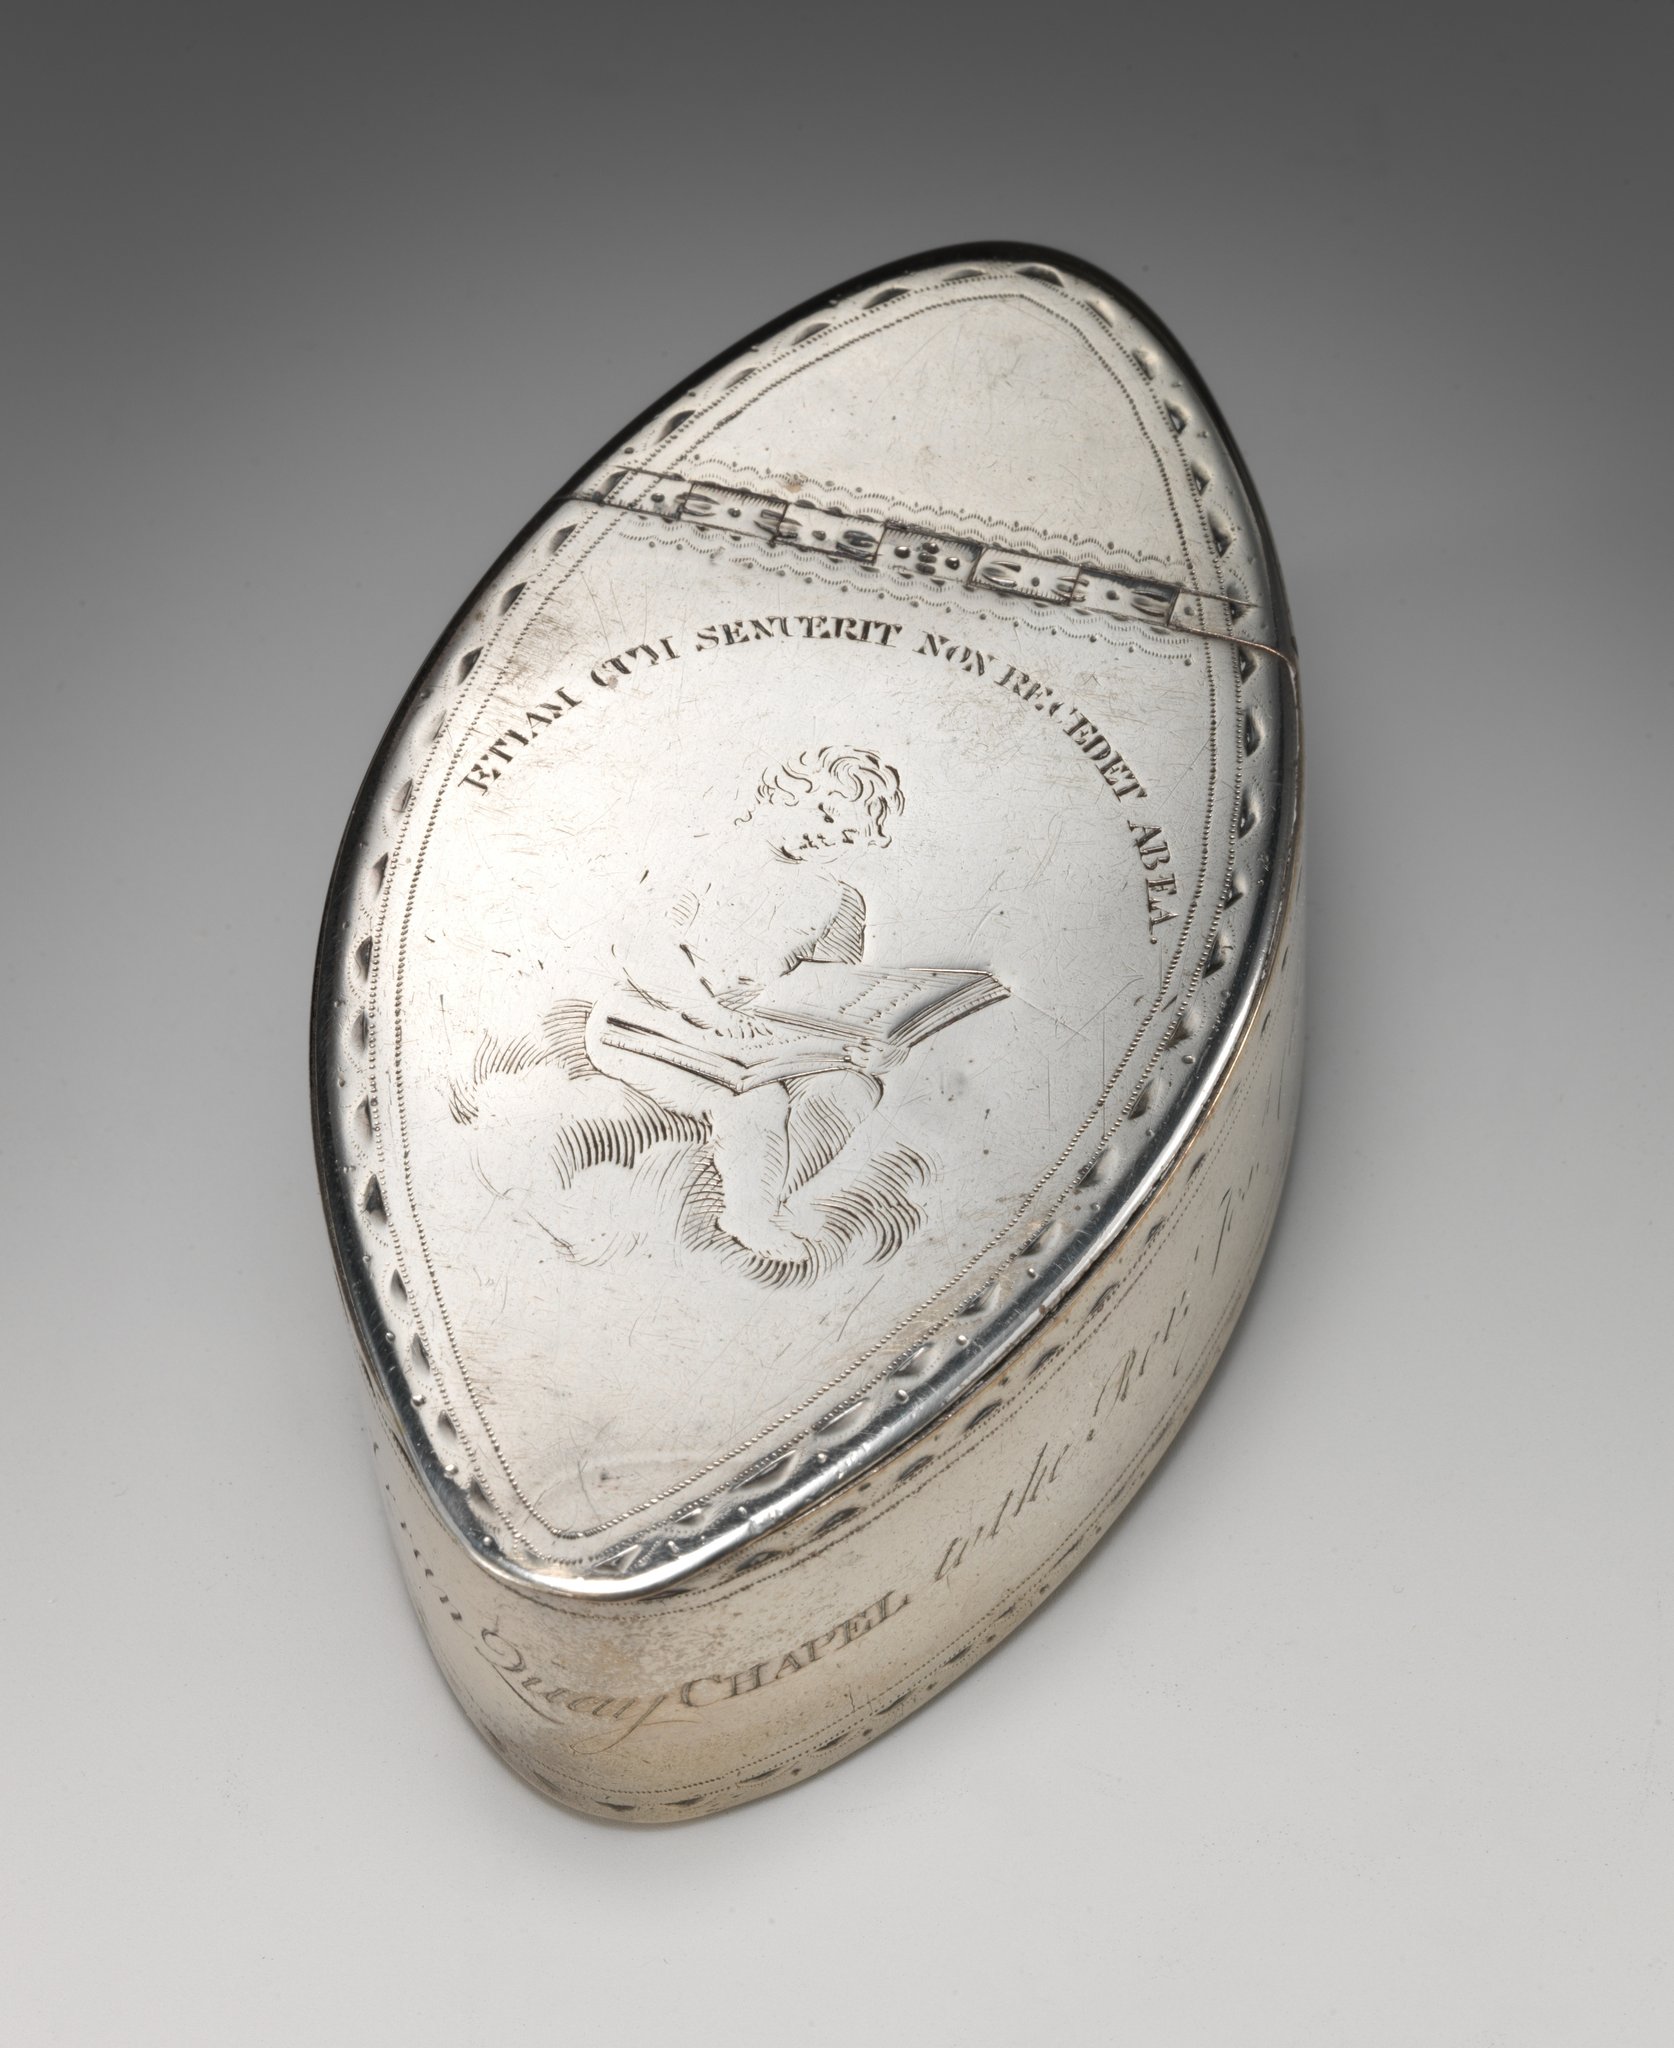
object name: snuffbox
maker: james kennedy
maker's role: maker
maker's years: 1703-1803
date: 1795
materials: silver